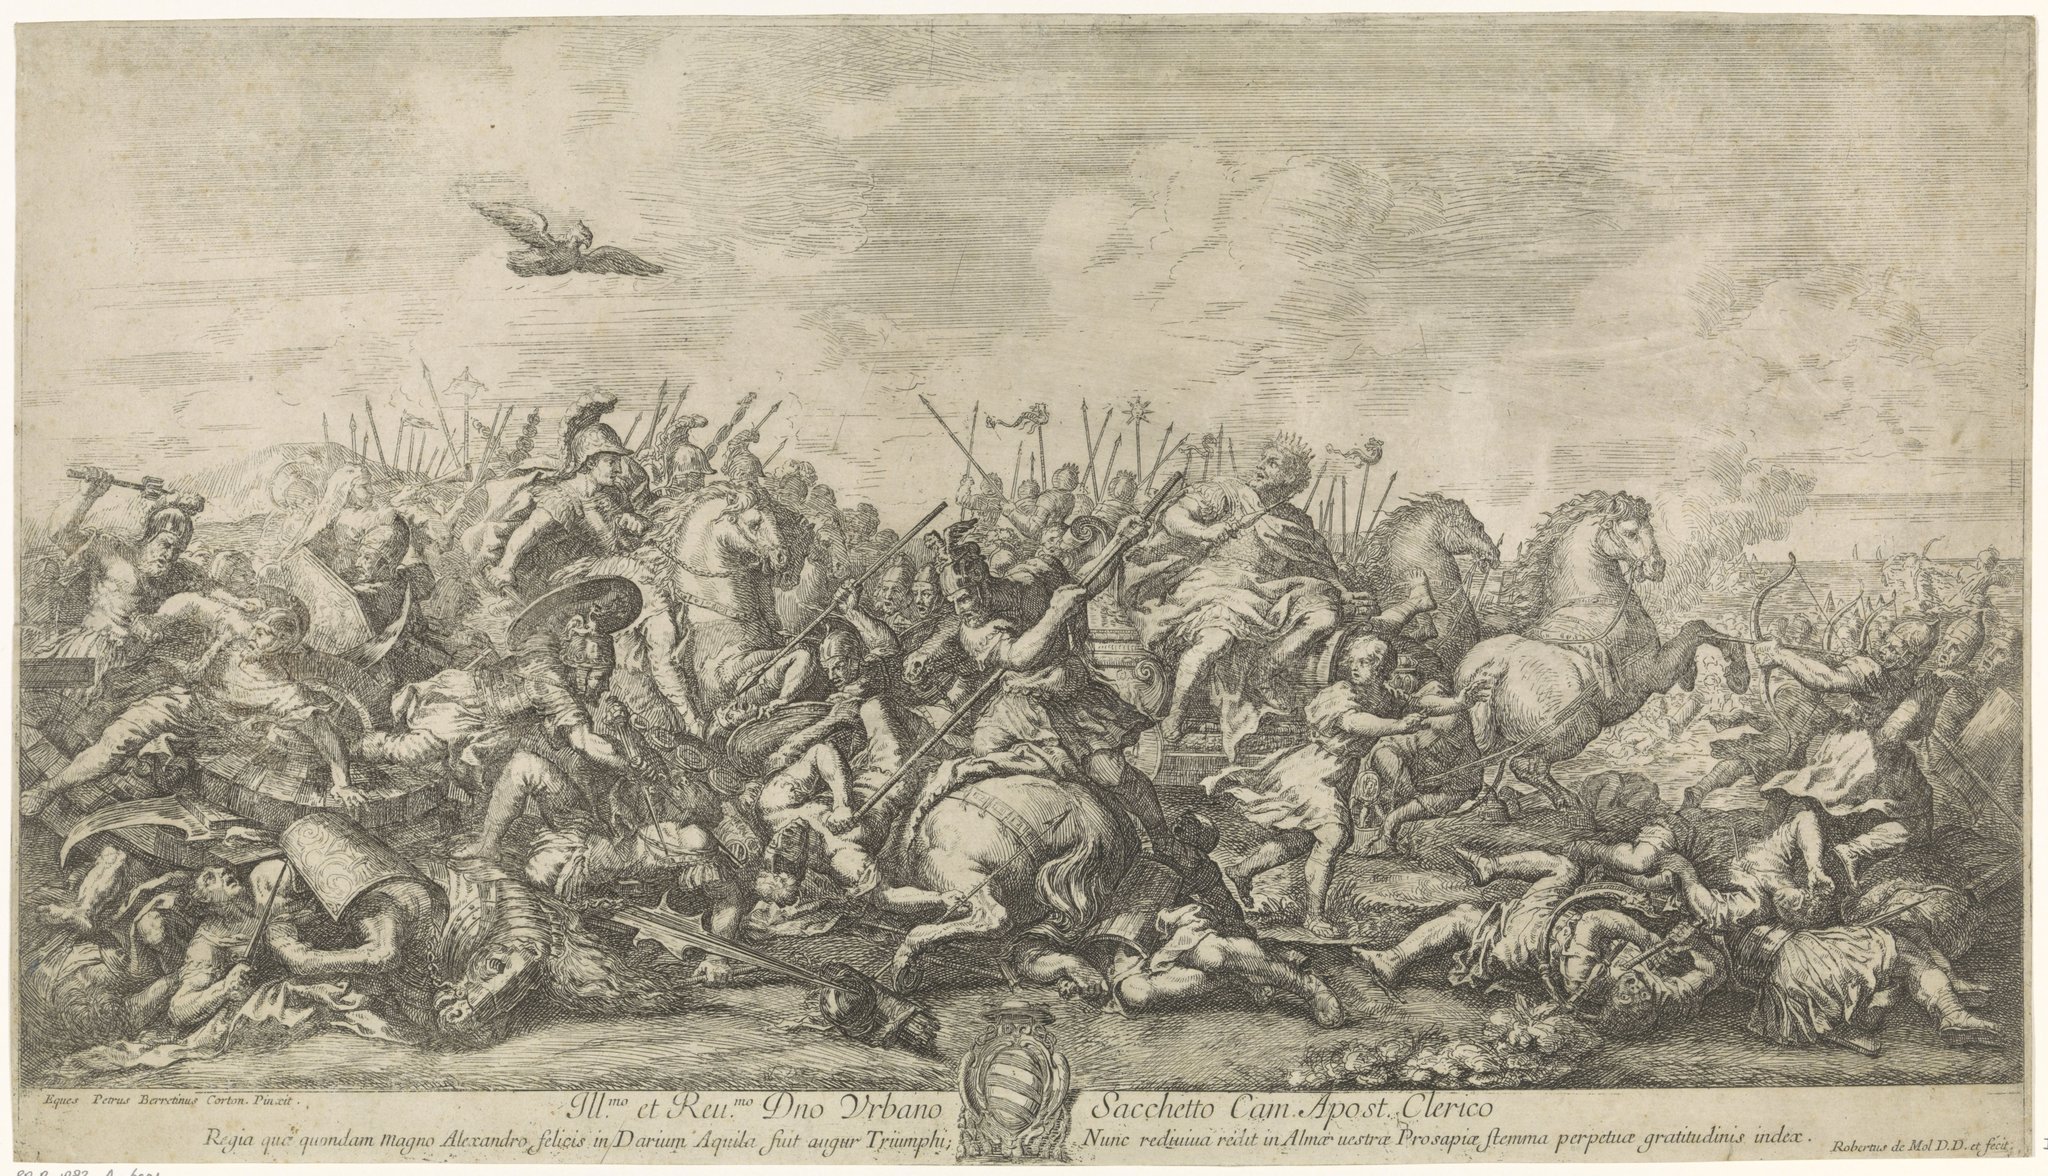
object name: print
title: Strijd tussen Alexander de Grote en Darius III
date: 1674-1682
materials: paper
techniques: engraving, etching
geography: rome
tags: alexander fighting against darius at issus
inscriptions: collector's mark: Lugt 2228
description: Alexander de Grote, links te paard, trekt met zijn leger op tegen koning Darius III van Perzië. Die kijkt verschrikt vanuit zijn strijdwagen achterom. Vermoedelijk de verbeelding van de slag bij Issus.